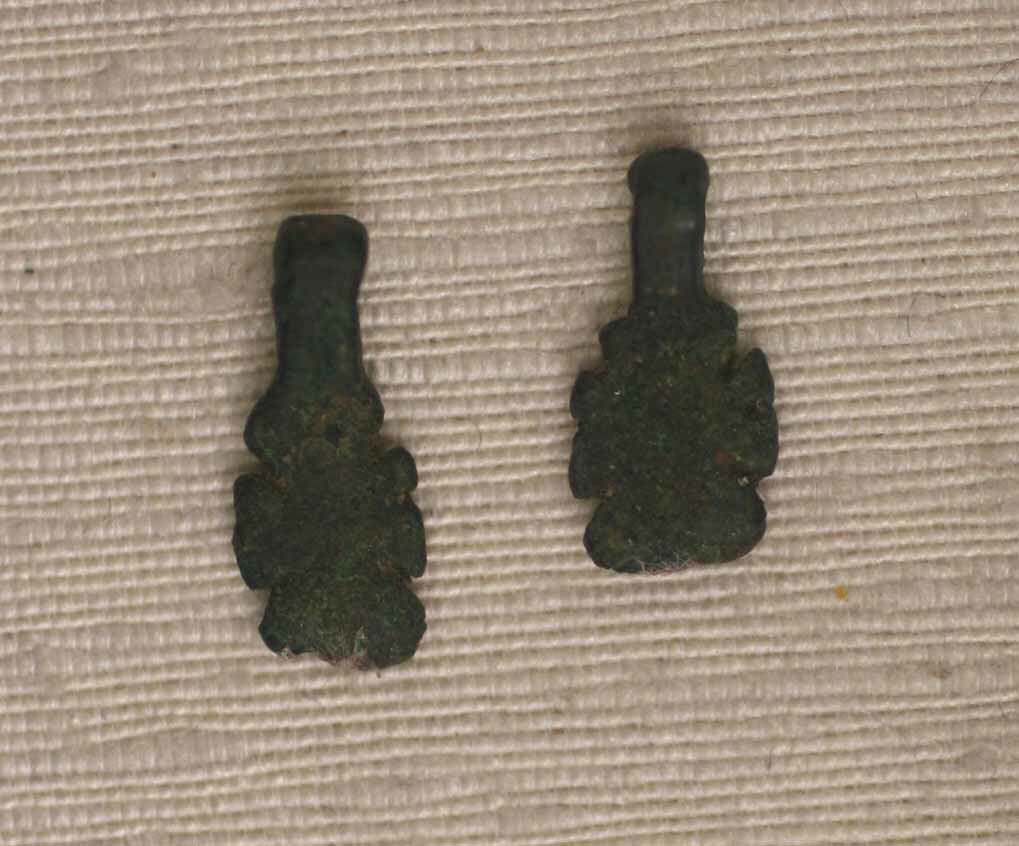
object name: pendant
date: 201-1200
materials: bronze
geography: egypt